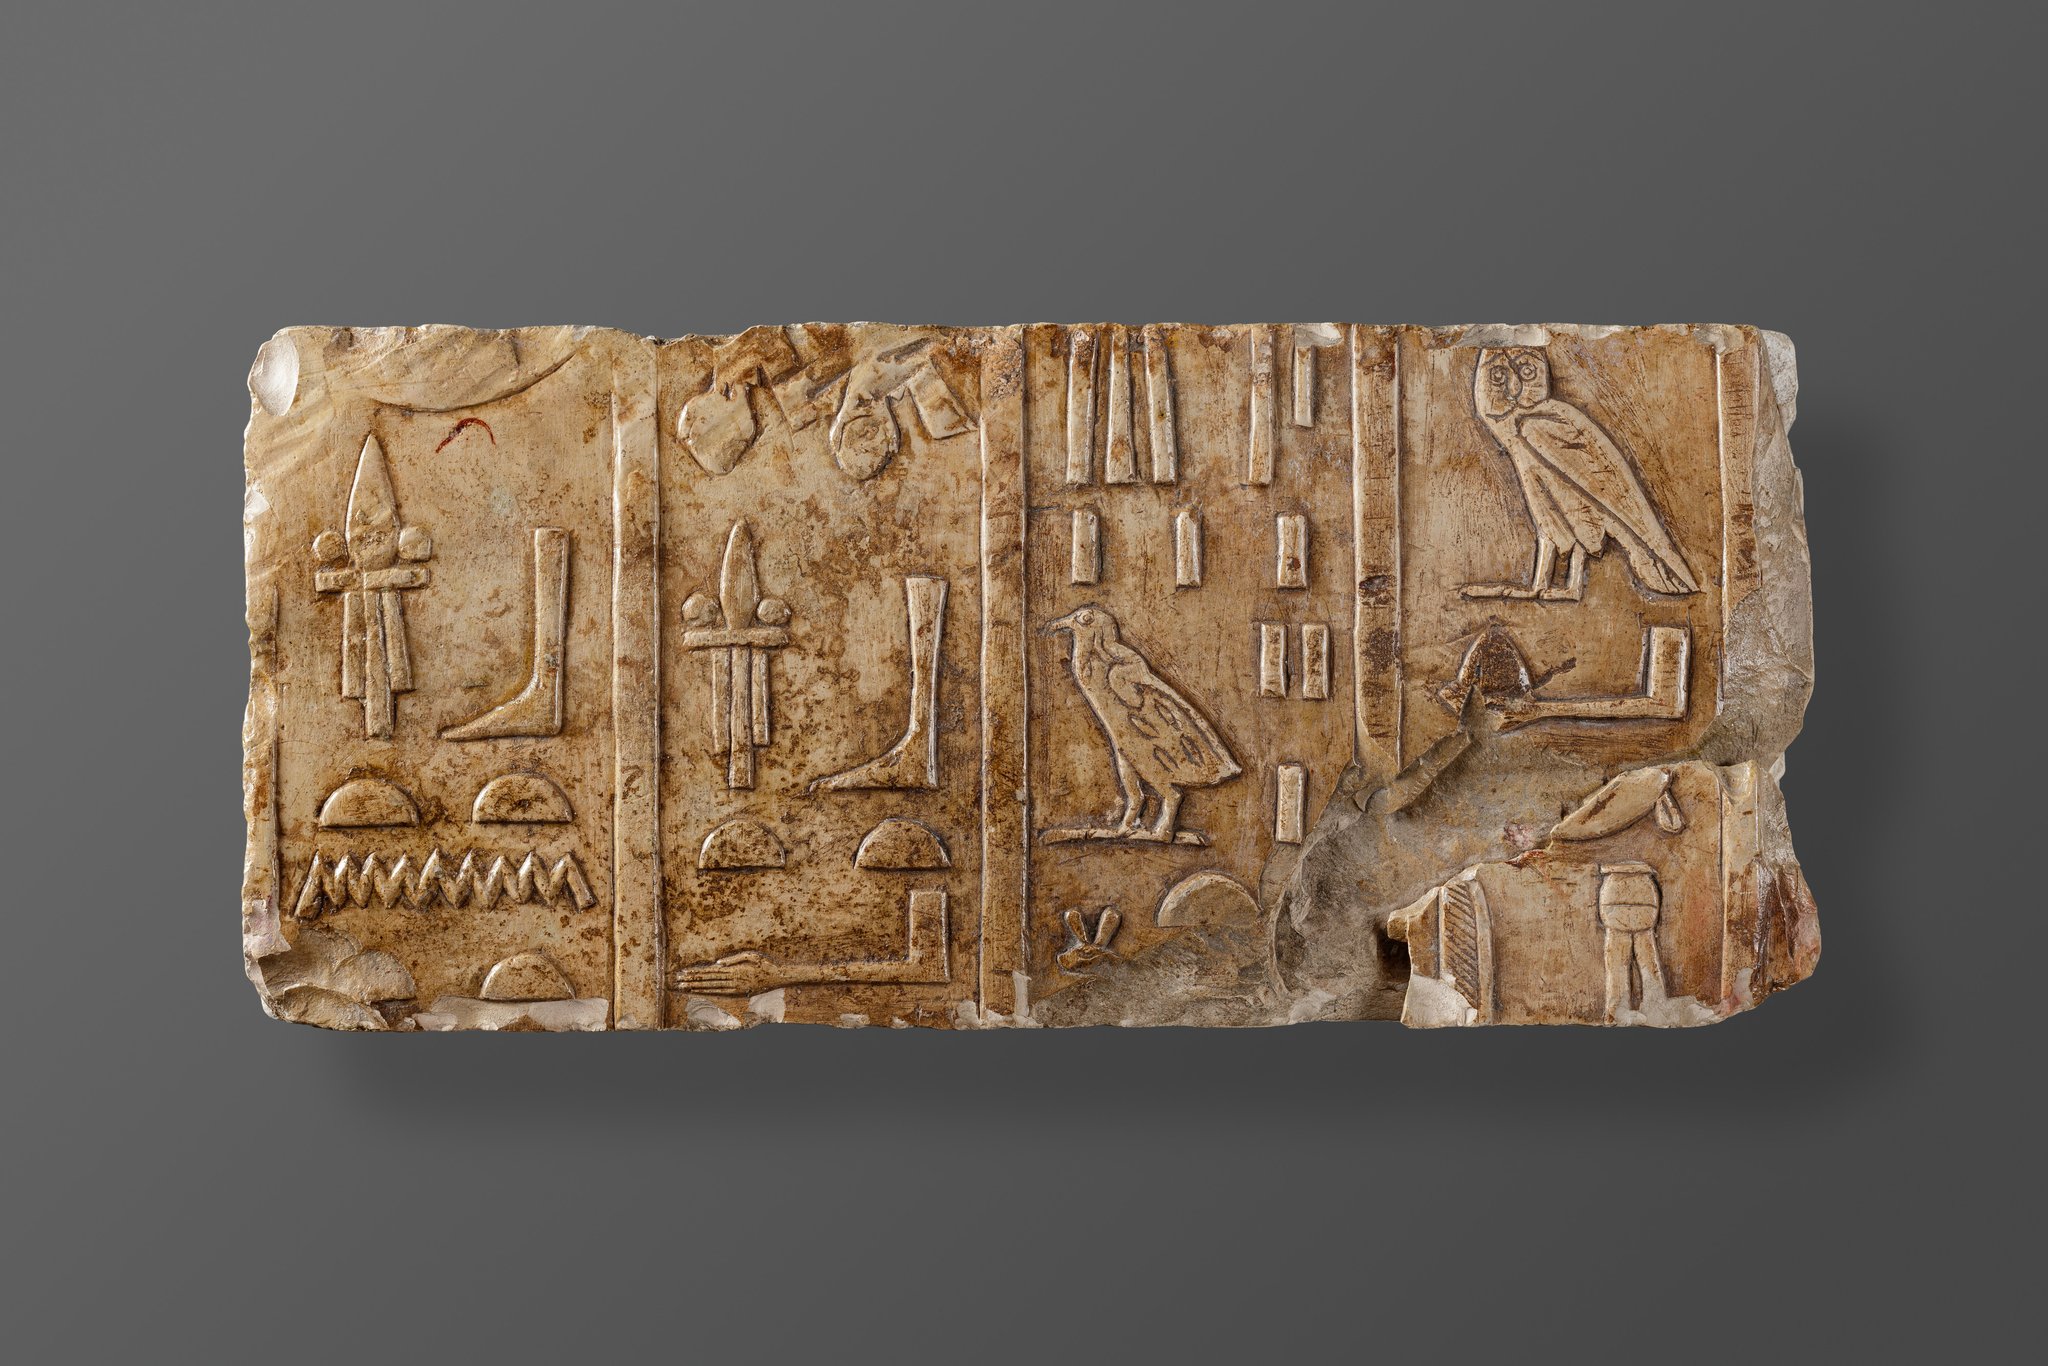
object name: relief, tomb of nespekashuty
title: Raised relief fragment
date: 664-610 BCE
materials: limestone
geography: egypt